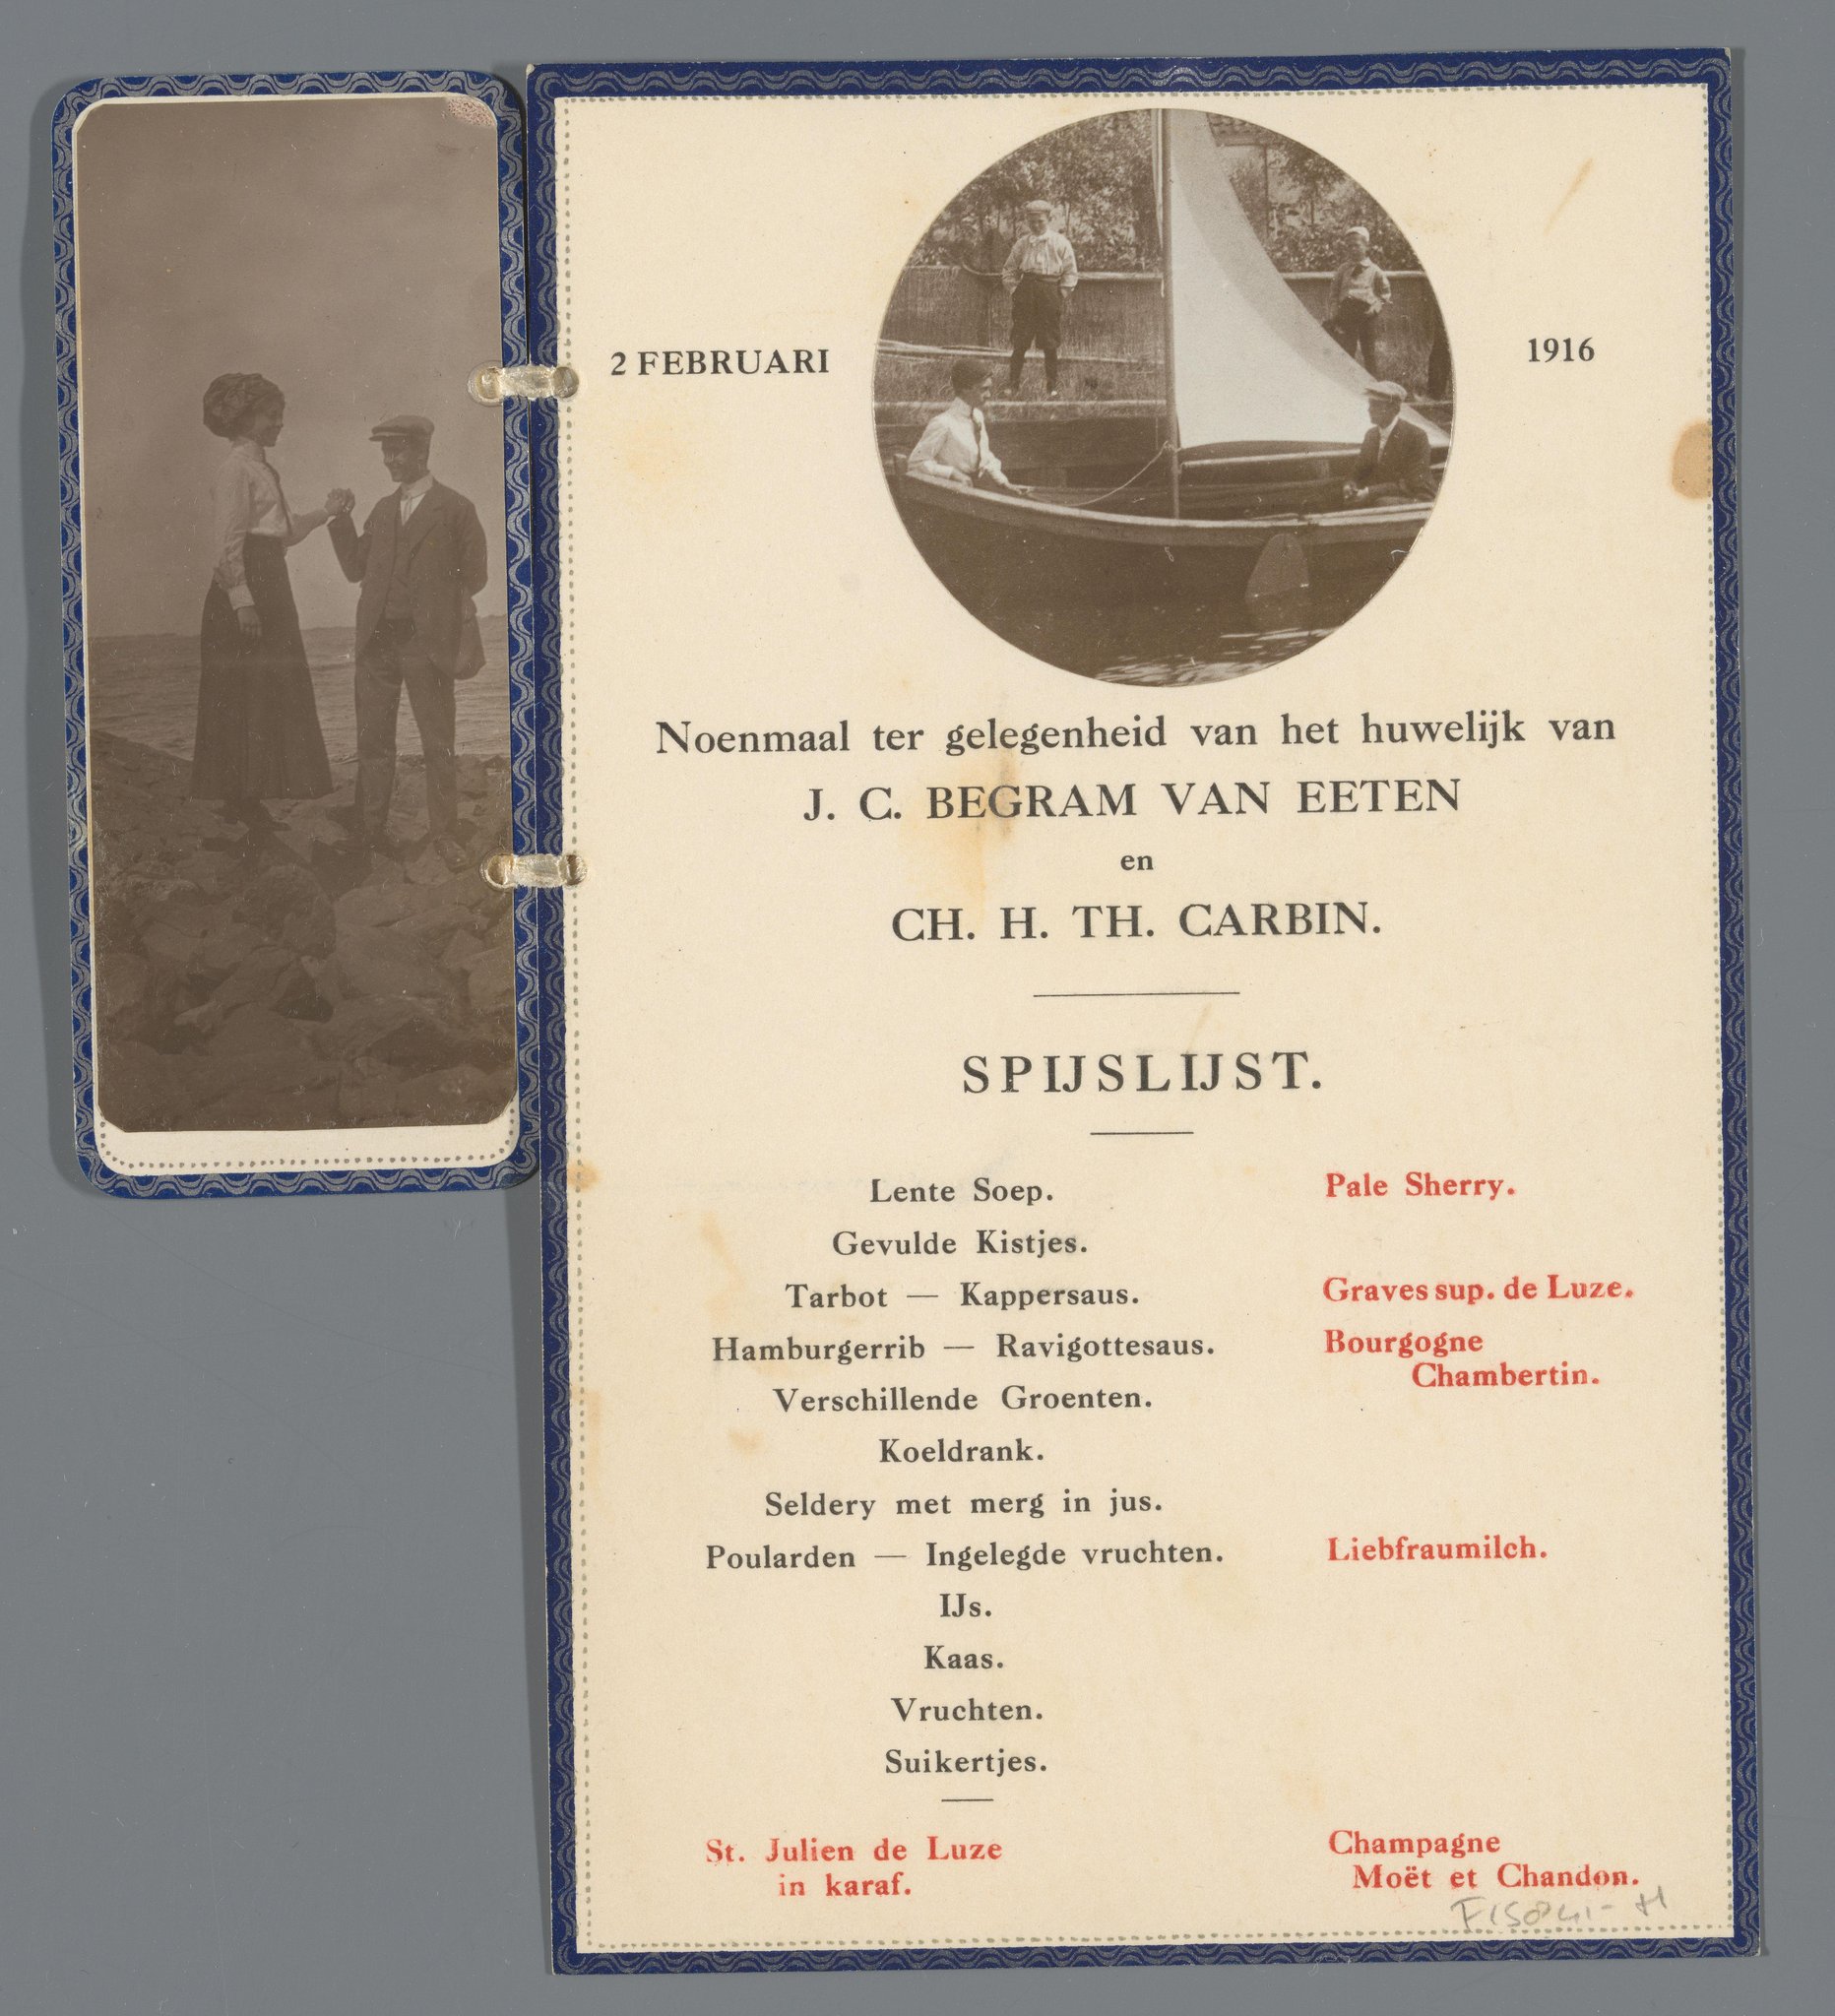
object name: photograph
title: Menukaart van de bruidegom voor het diner ter ere van het huwelijk tussen J.C. Begram van Eeten en Ch.H.Th. Carbin; met portretten van het paar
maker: Anonymous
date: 1916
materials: paper, pencil, textile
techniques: letterpress printing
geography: netherlands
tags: amsterdam, engineer, sailing-ship, sailing-boat, (civil) marriage ceremonies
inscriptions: signature: ‘(...)’, inscription: ‘Noenmaal ter gelegenheid van het huwelijk van/ J.C. Begram van Eeten/ en/ Ch. H. Th. Carbin./ Spijslijst. (...)’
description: Op de achterzijde handtekeningen van de gasten.